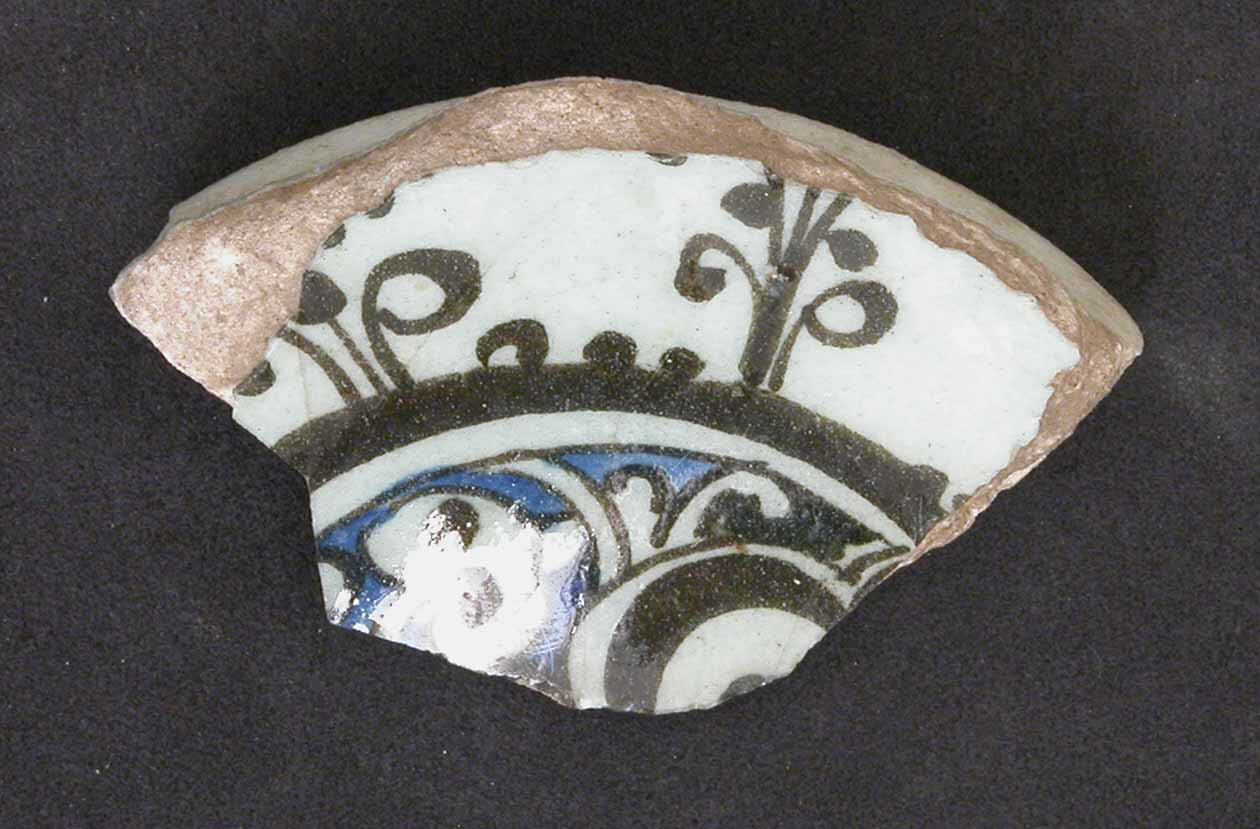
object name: fragment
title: Fragment of a Bowl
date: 1201-1300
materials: stonepaste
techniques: painting, underglaze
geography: syria